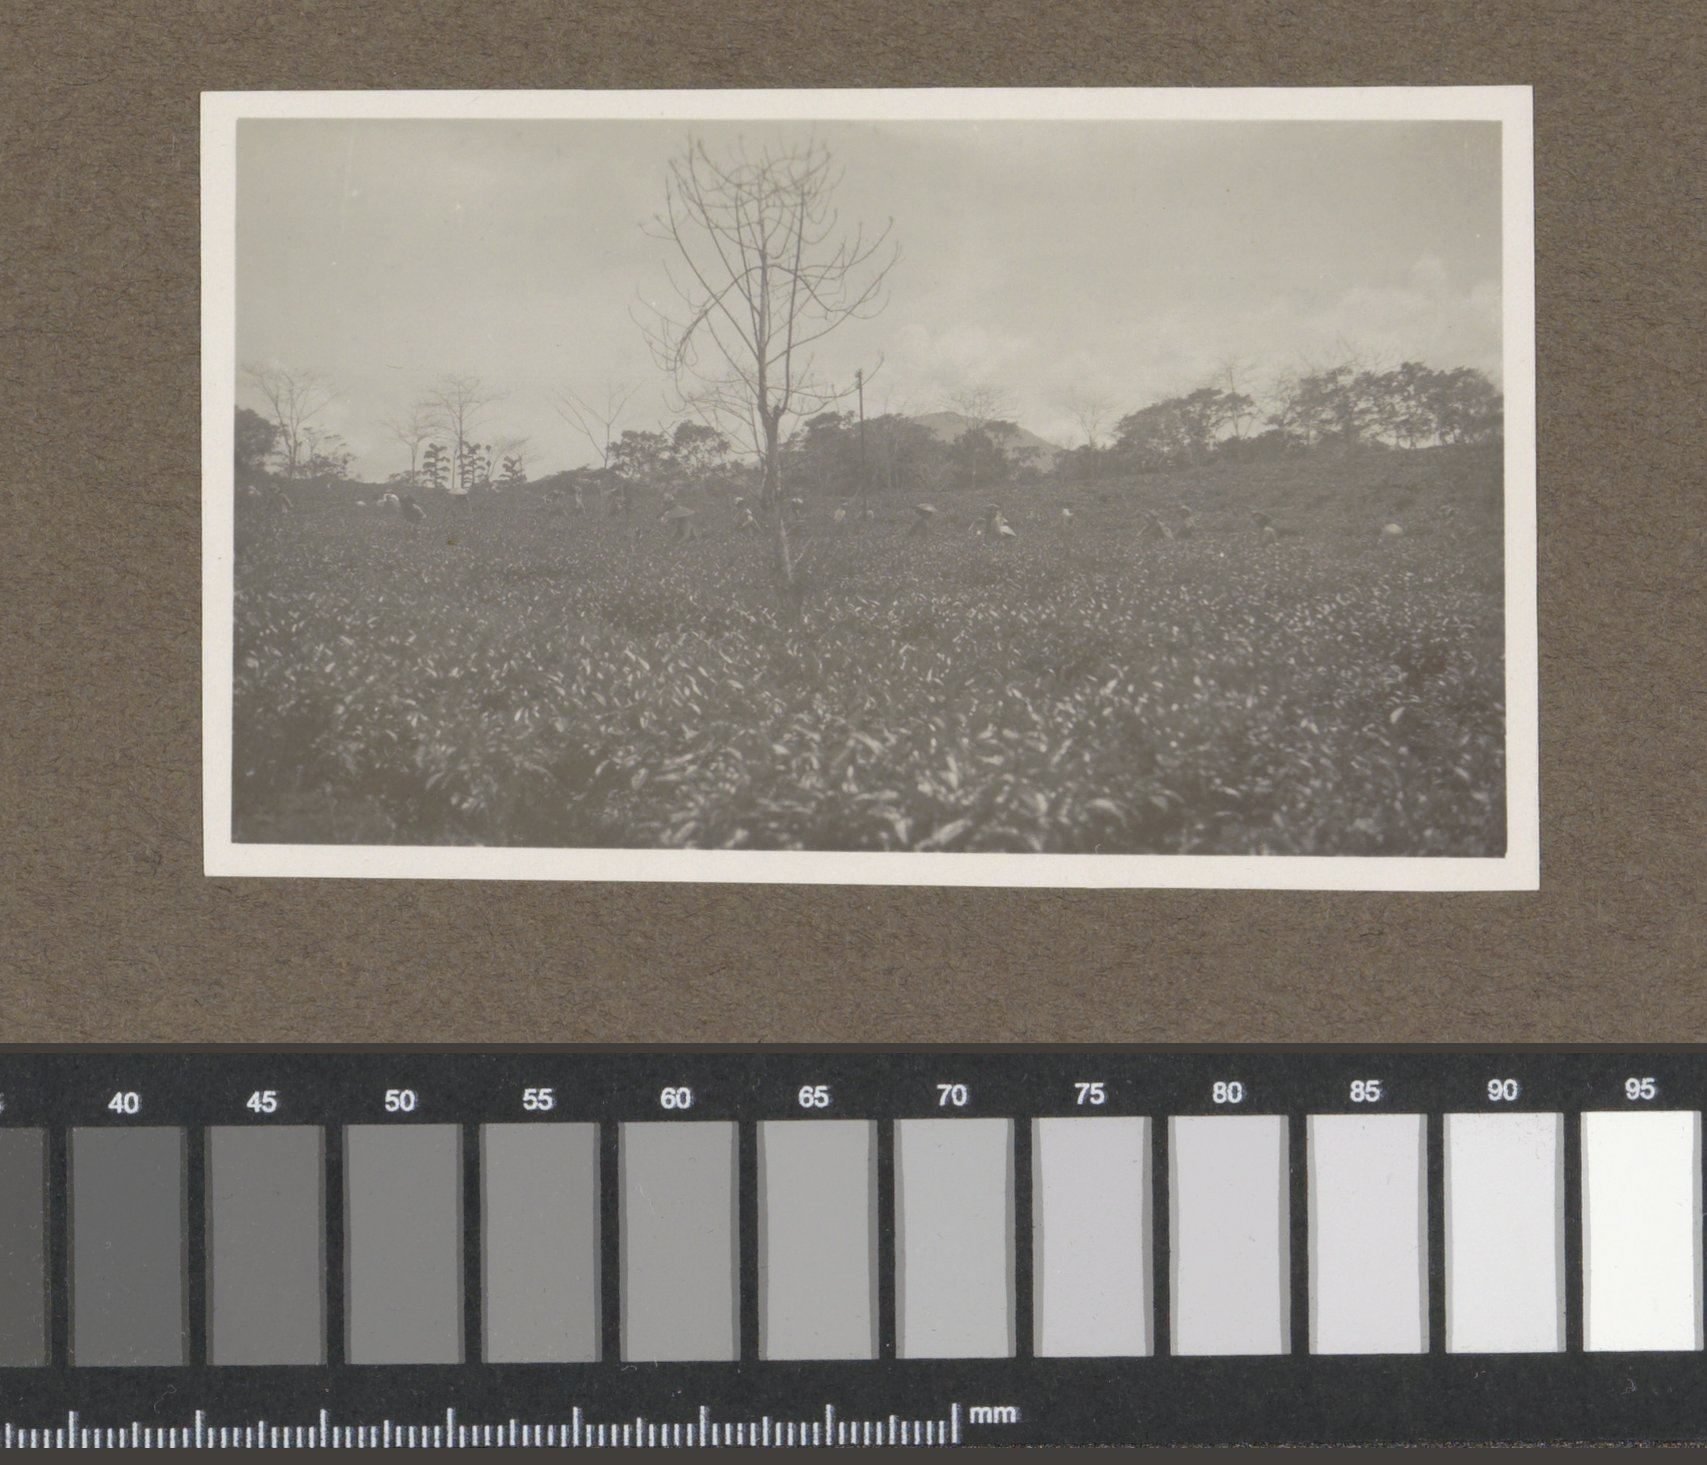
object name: photograph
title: Plantageveld met pluksters in Nederlands-Indië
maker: klaas kleiterp (i)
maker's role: arts, officier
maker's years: 1892-1943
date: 1920-1930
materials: paper, photographic support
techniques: gelatin silver print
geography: dutch east indies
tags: plantation, field filled with a crop, reaping, picking, mowing ~ harvest, dutch east indies, the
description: Onderdeel van Fotoalbum van de familie Kleiterp-Vermeulen met opnames van Nederlands-Indië.